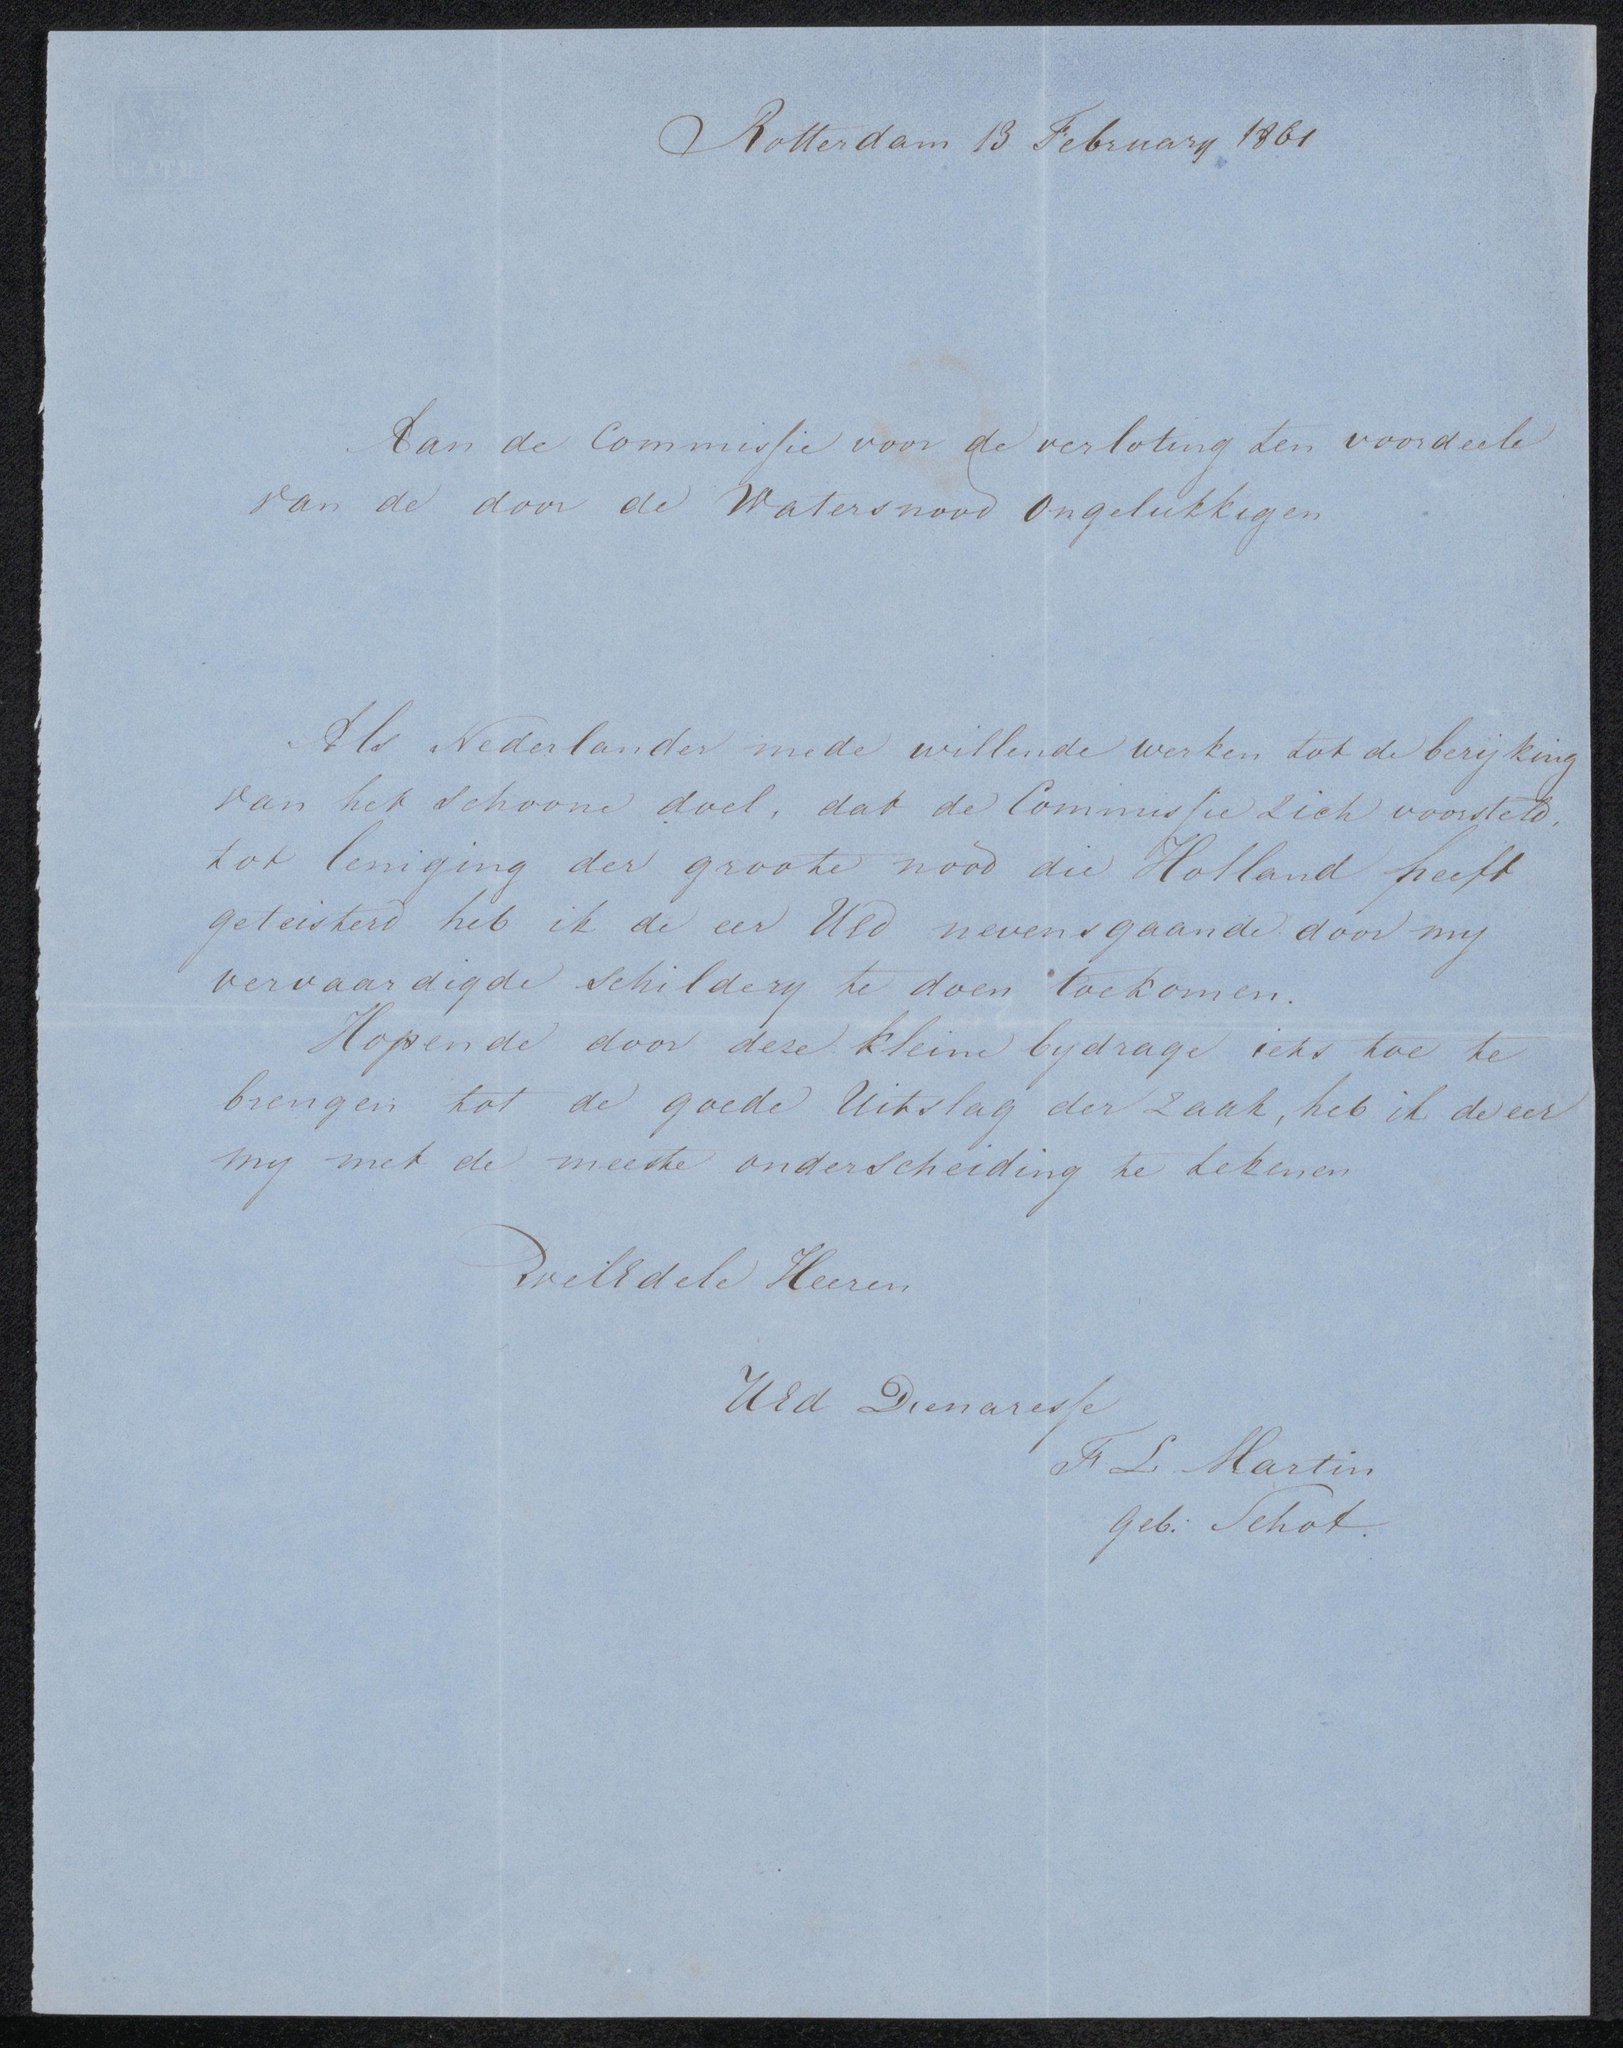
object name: letter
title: Brief aan Ary Johannes Lamme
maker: francina louise schot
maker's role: painter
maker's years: 1816-1894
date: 1861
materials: ink, paper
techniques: pen, writing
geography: rotterdam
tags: dordrecht, print maker, ary johannes lamme, painting (including book-illumination, miniature-painting), charitable works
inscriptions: collector's mark: Lugt 2228